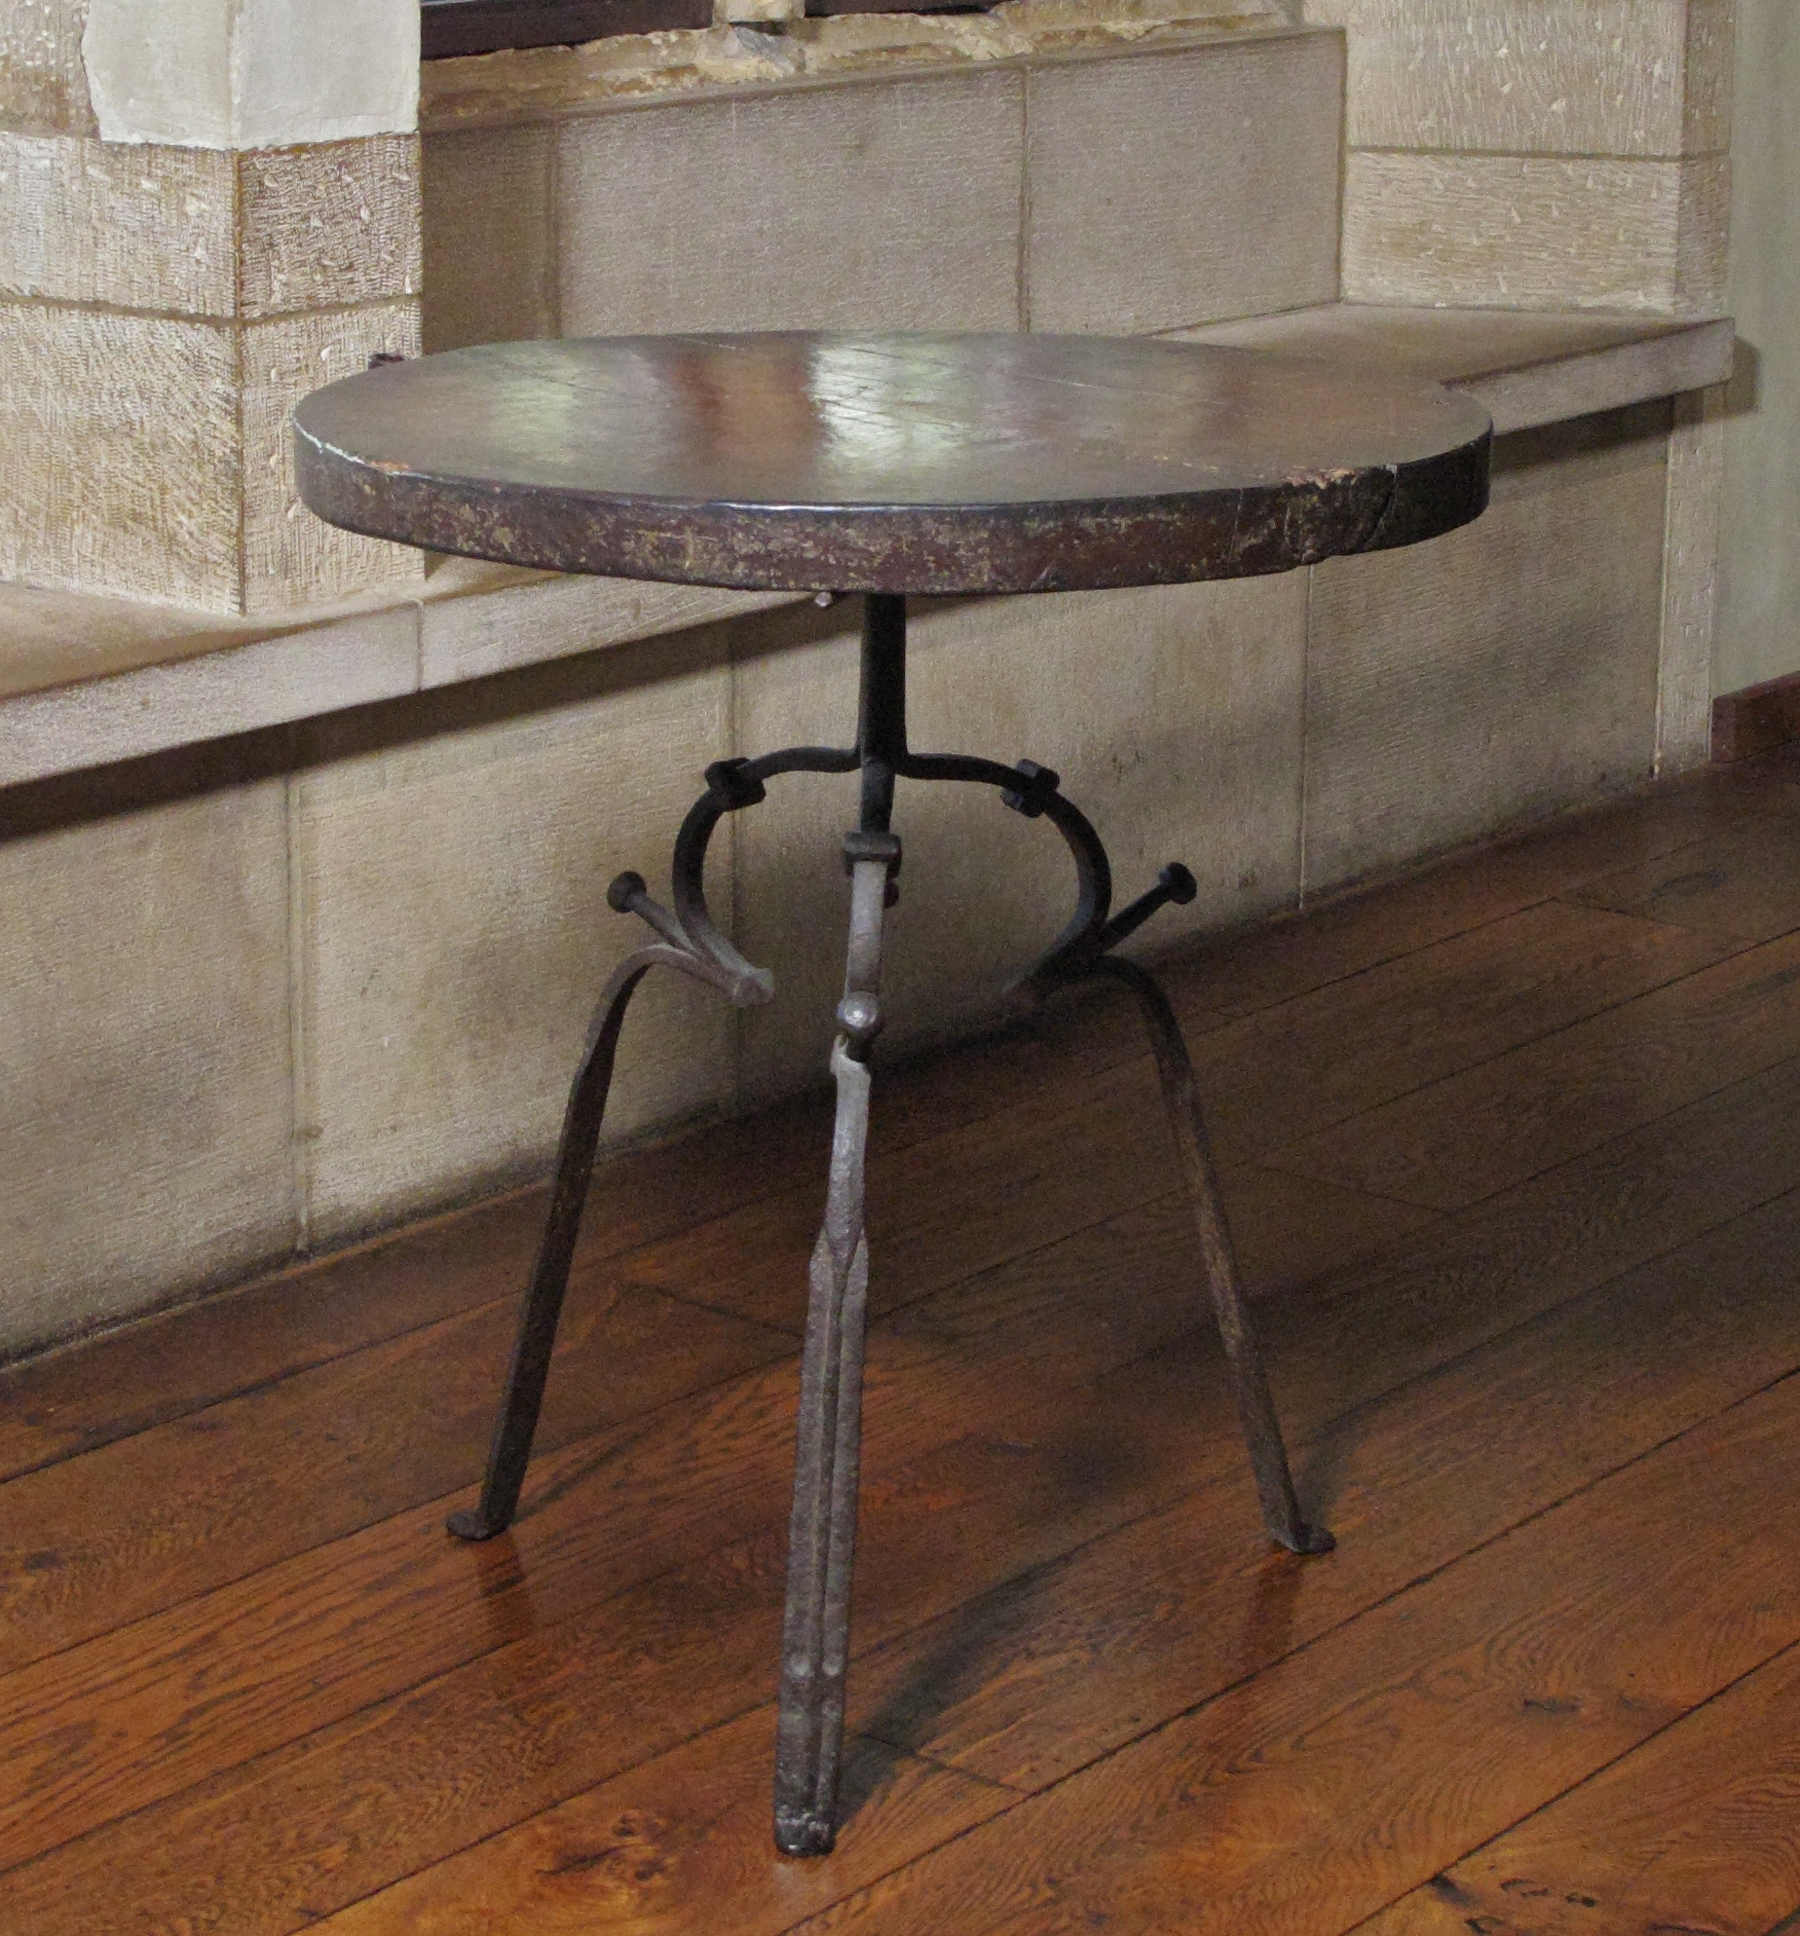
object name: table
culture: french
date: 1401-1500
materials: iron, wood